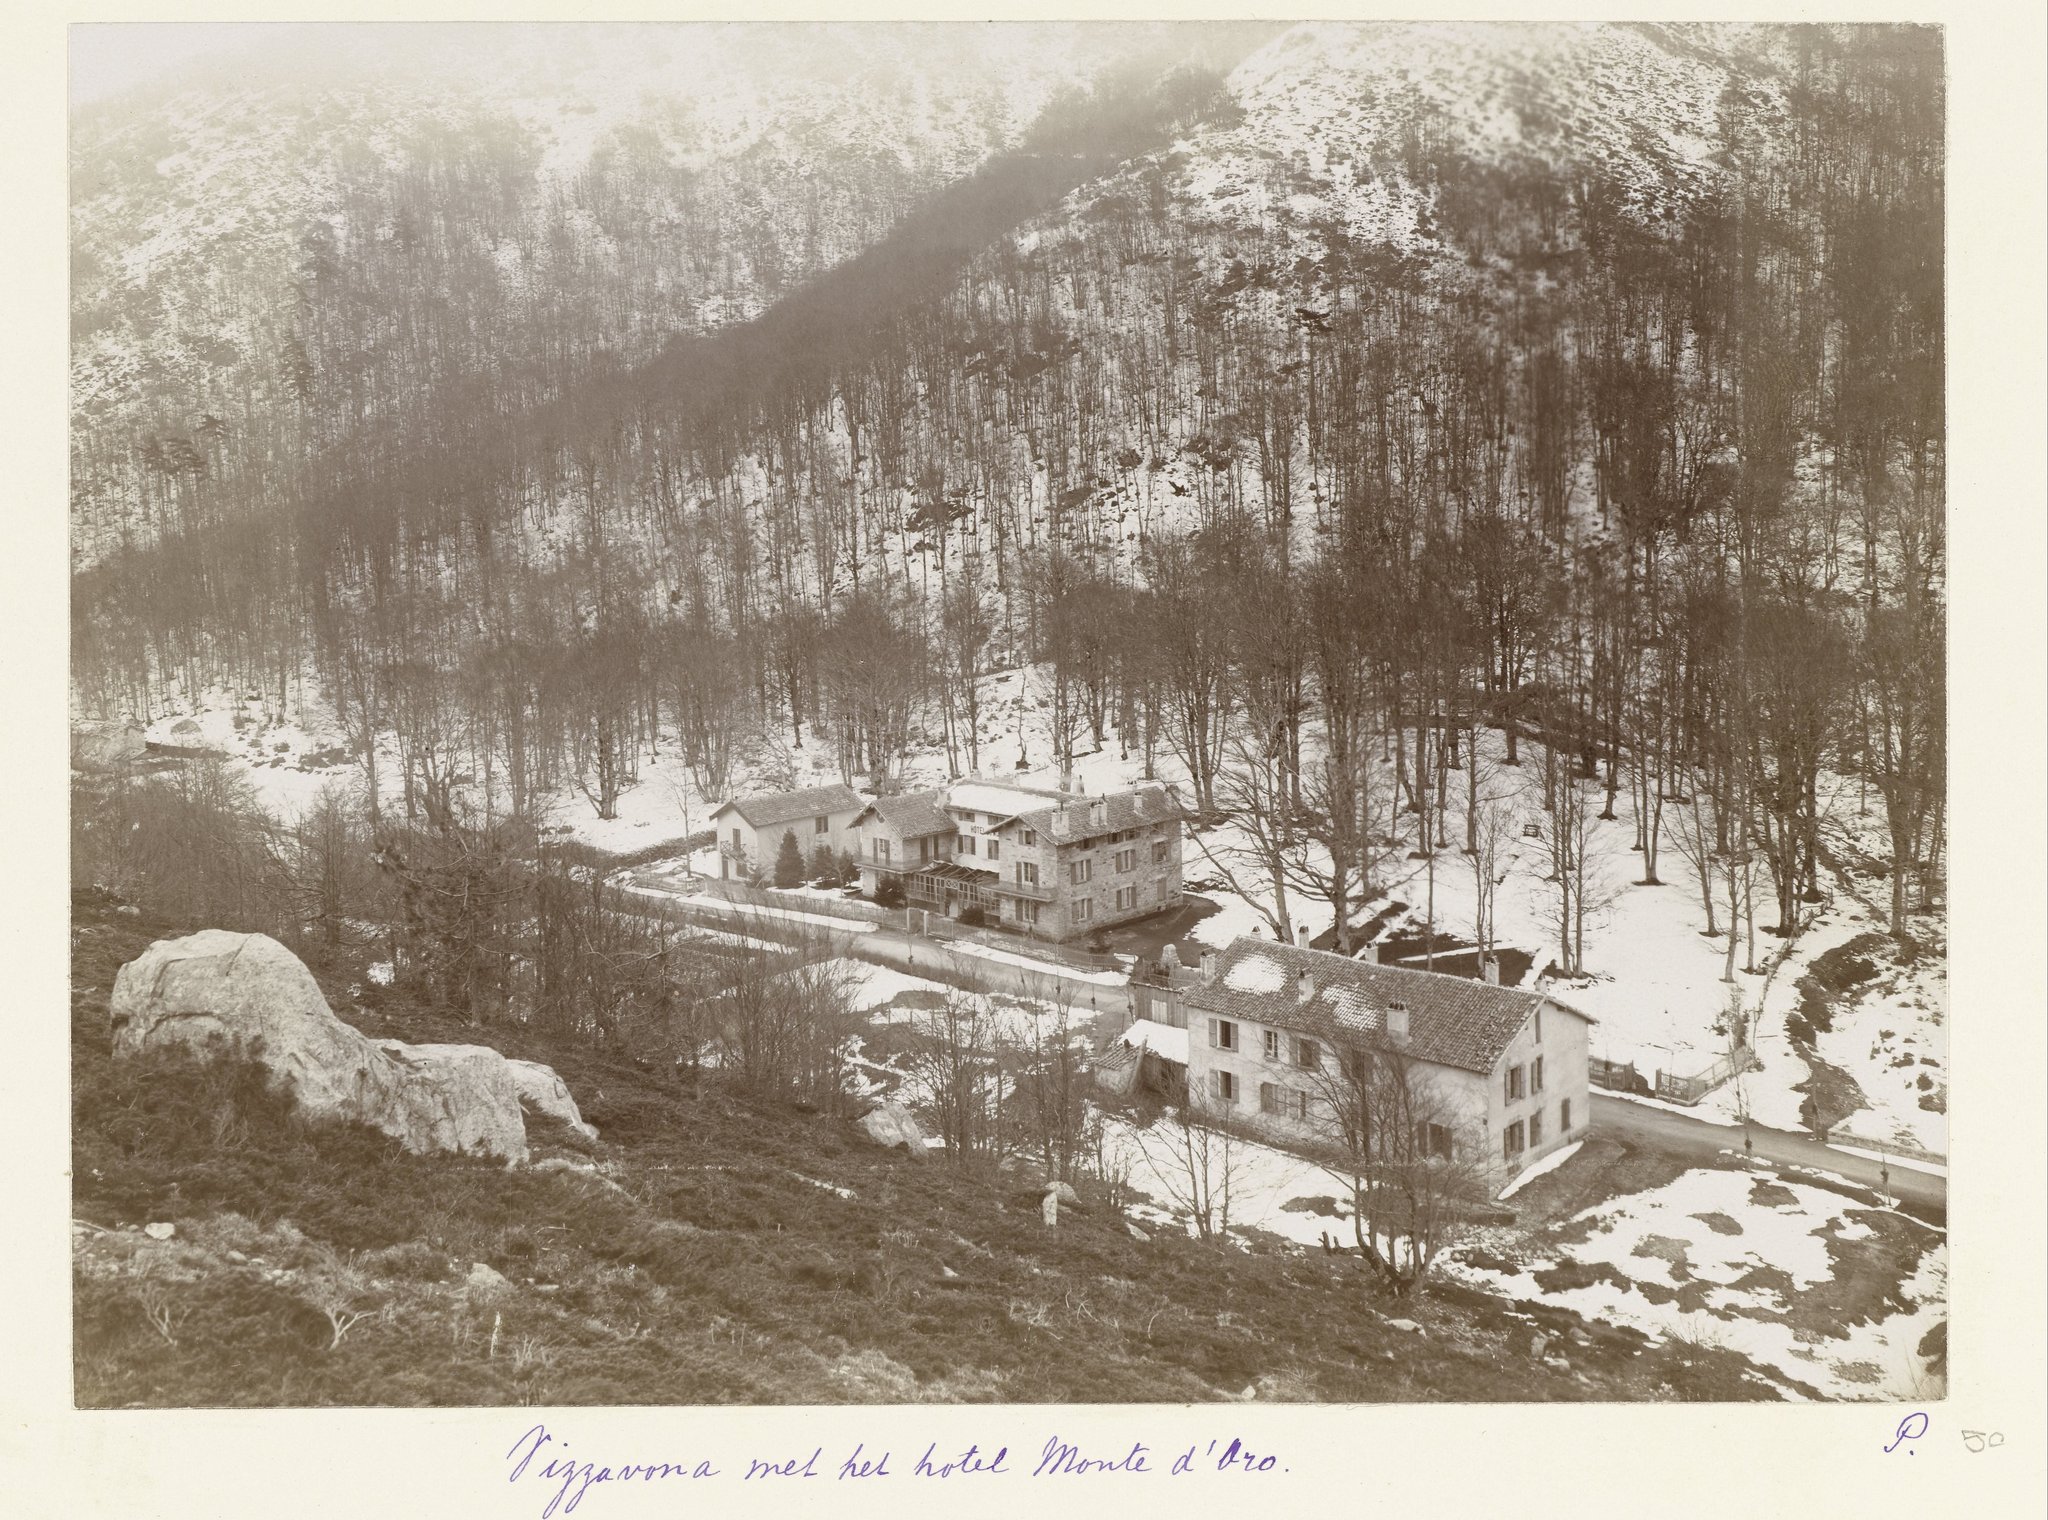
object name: photograph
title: Hotel Monte d'Oro in Vizzavona in een besneeuwd berglandschap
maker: henry pauw van wieldrecht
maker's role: fotograaf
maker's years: 1863-1912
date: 1886-1896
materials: cardboard, photographic support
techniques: albumen print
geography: corsica